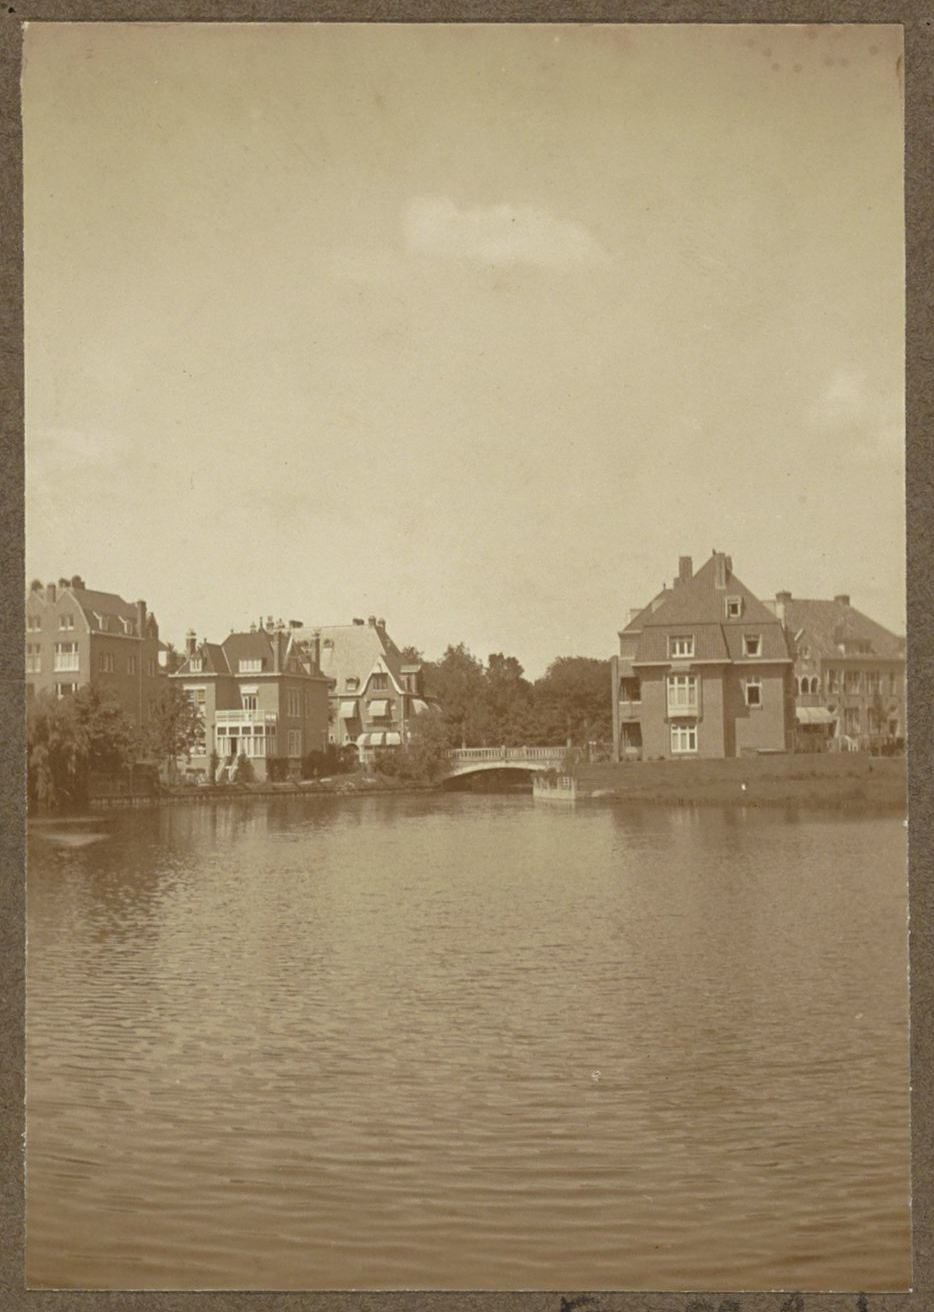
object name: photograph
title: Huizen aan het water bij de Oranje Nassaulaan te Amsterdam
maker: Anonymous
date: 1910-1930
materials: paper, photographic support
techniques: gelatin silver print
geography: amsterdam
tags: villa, pond, pool, amsterdam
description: Onderdeel van Album met foto's van Amsterdam en omgeving.